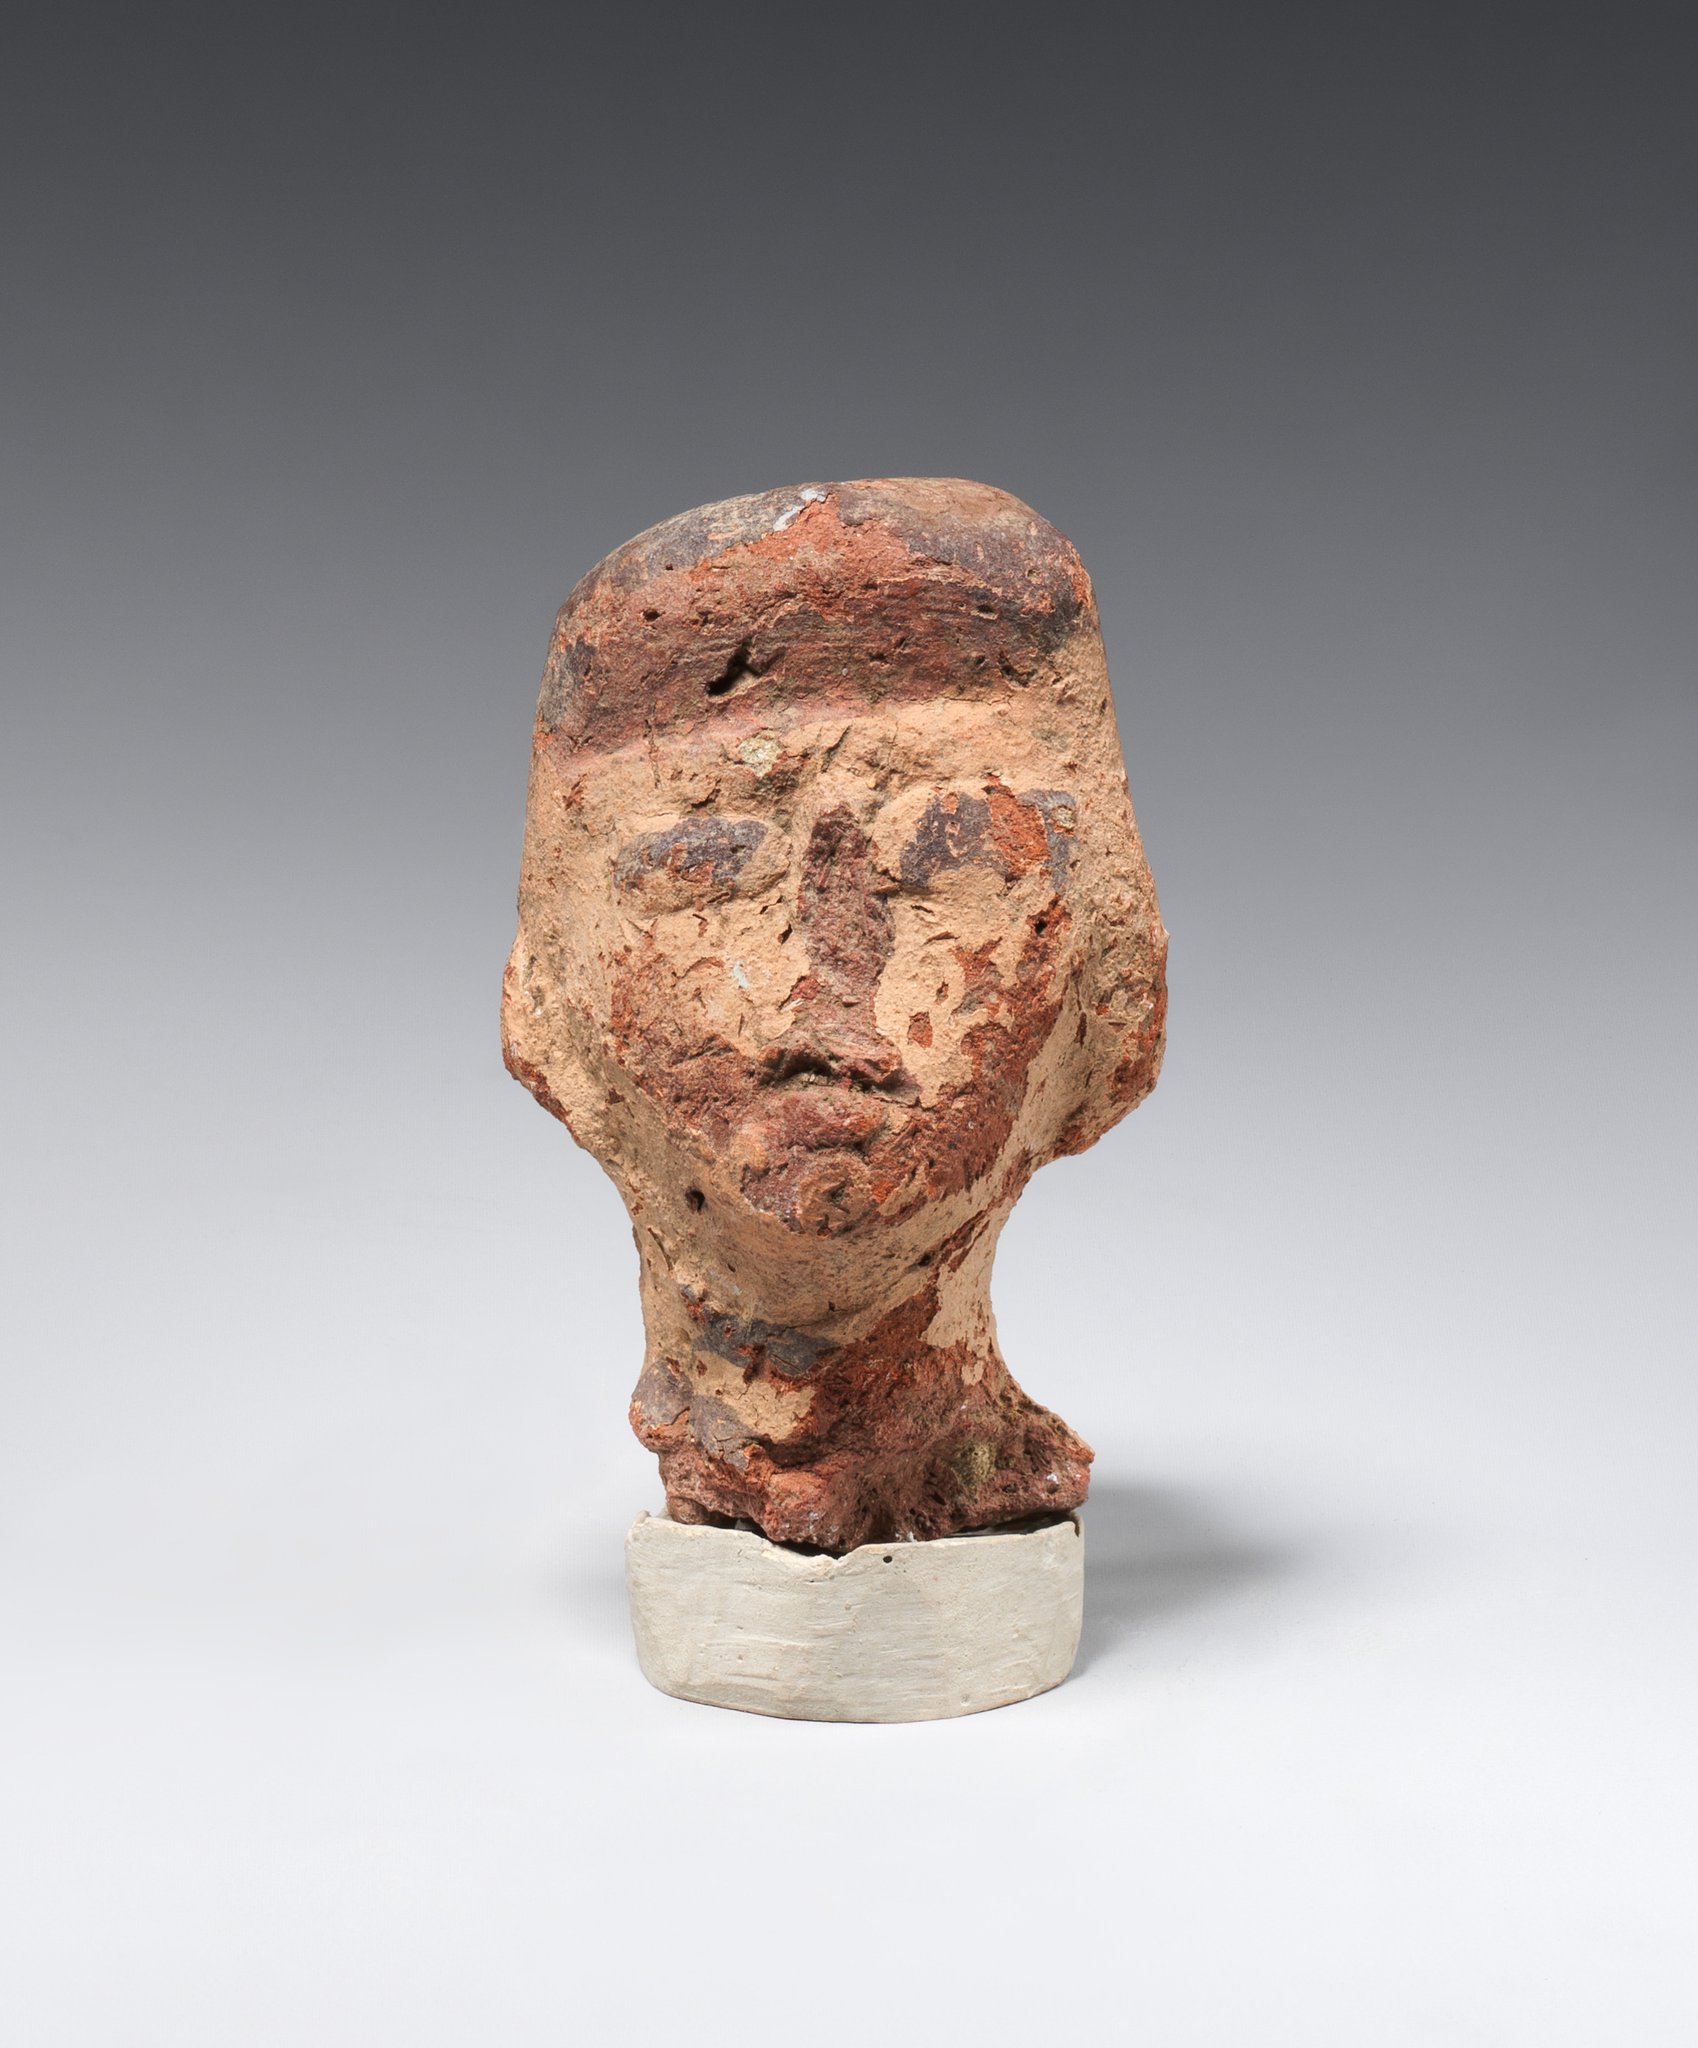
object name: head fragment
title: Head from a figurine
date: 332-330 BCE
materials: paint, pottery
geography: egypt